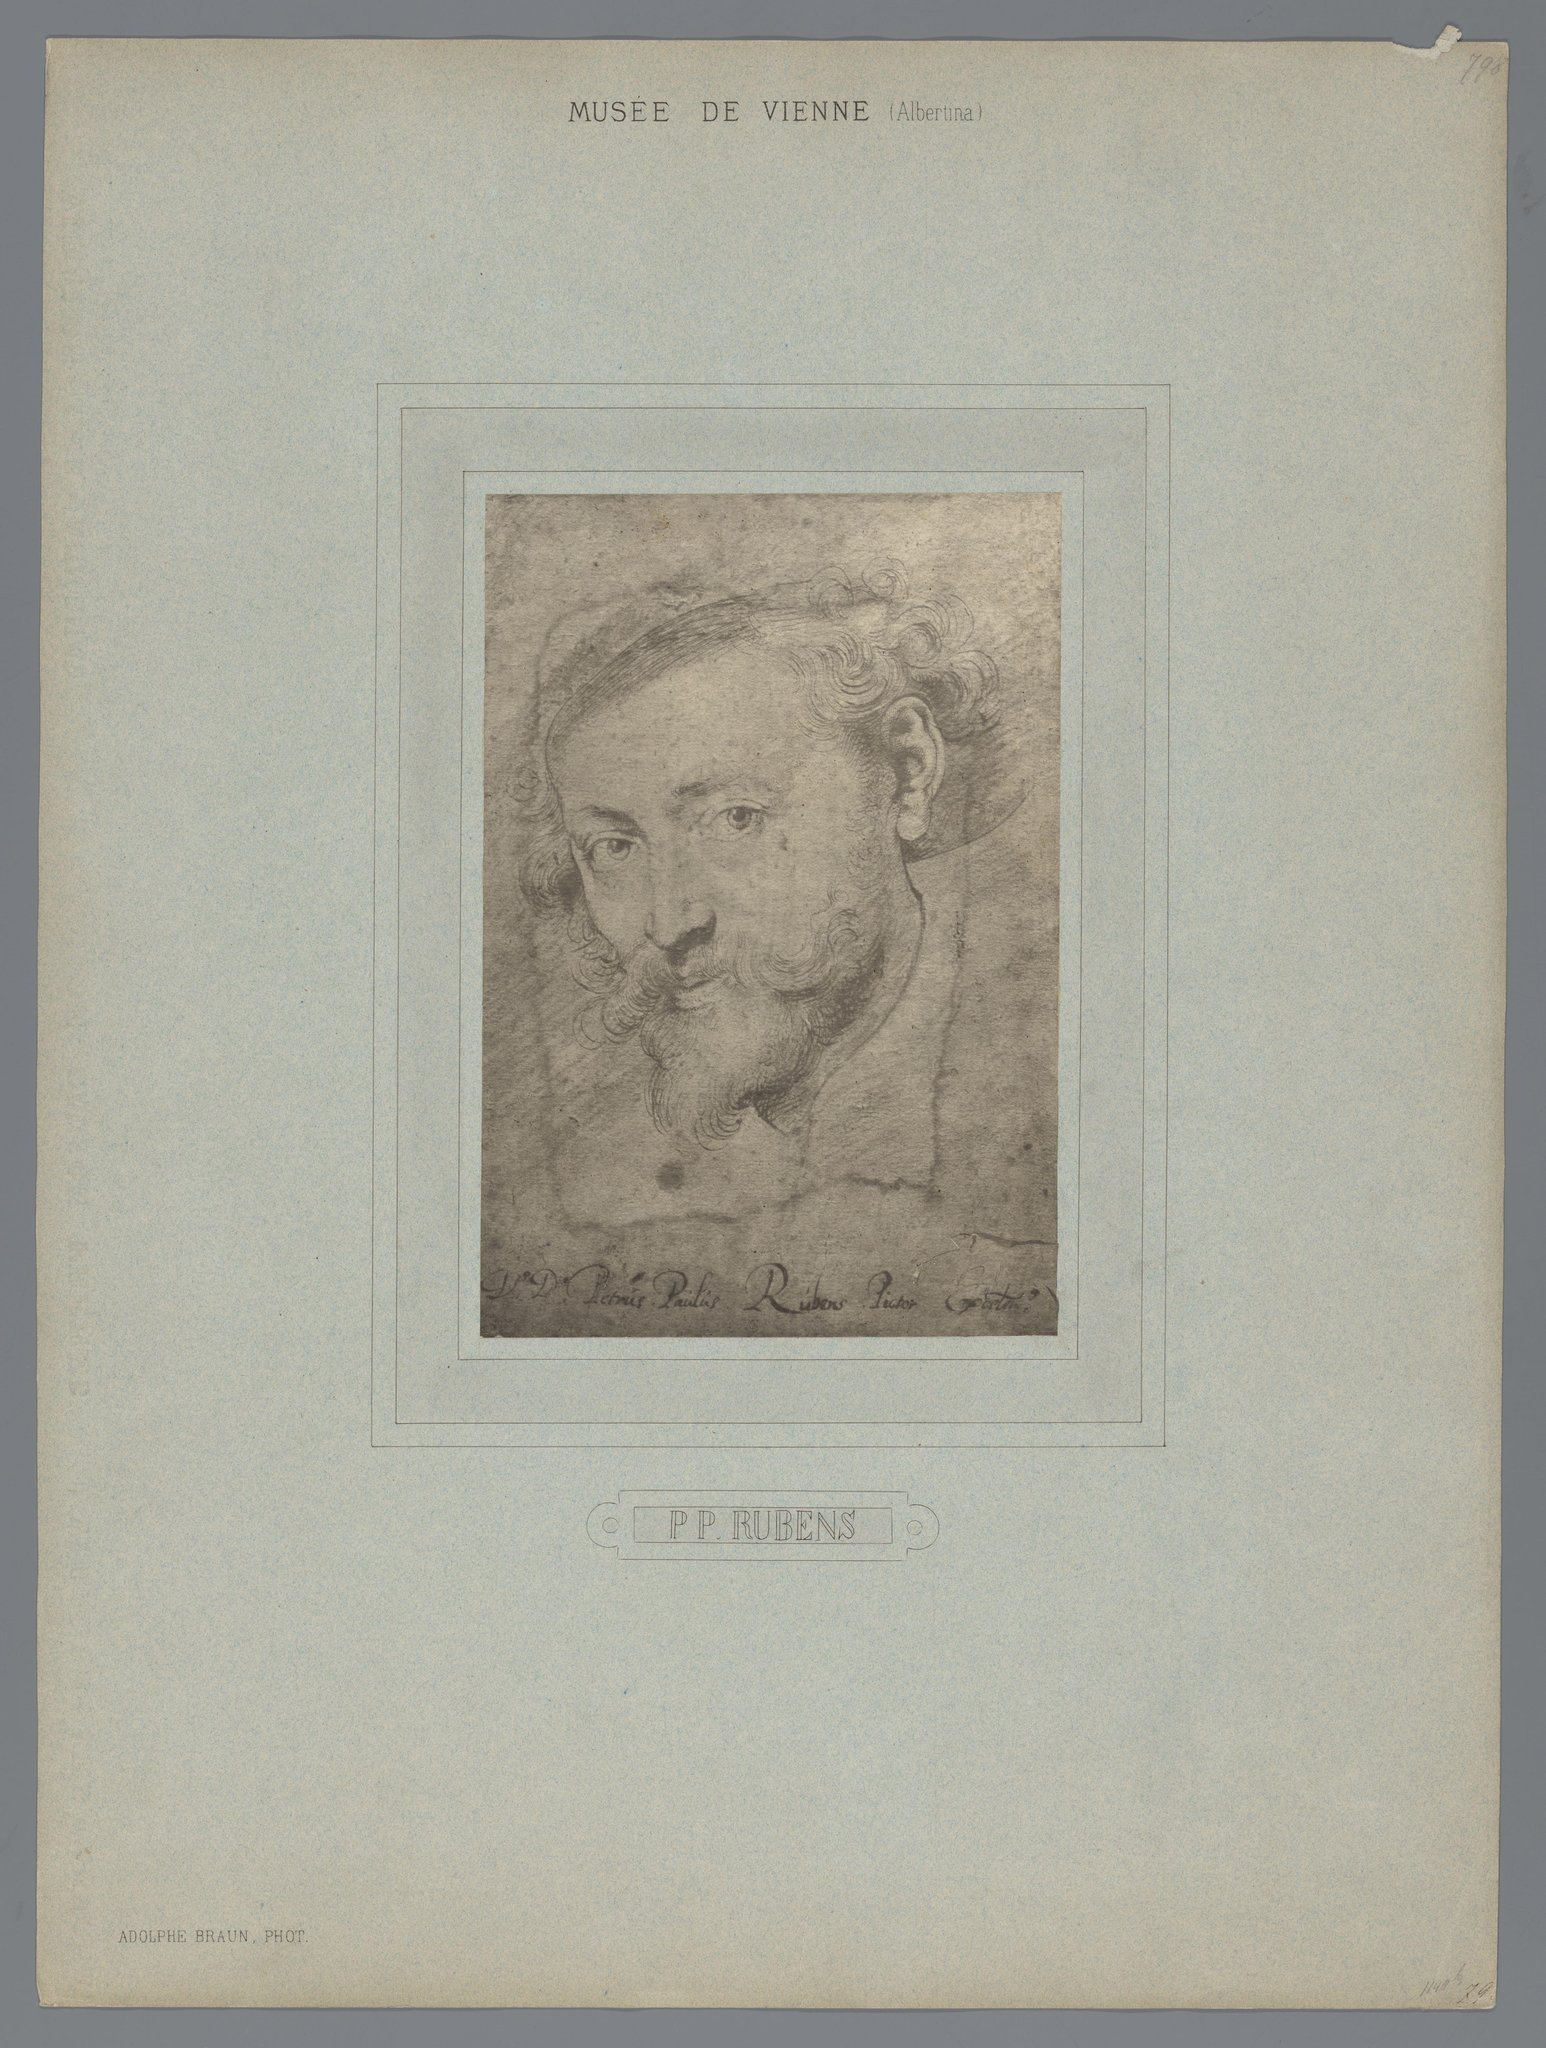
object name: photograph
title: Fotoreproductie van een tekening van Peter Paul Rubens (kop van een man)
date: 1880-1900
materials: cardboard, paper, photographic support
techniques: carbon print